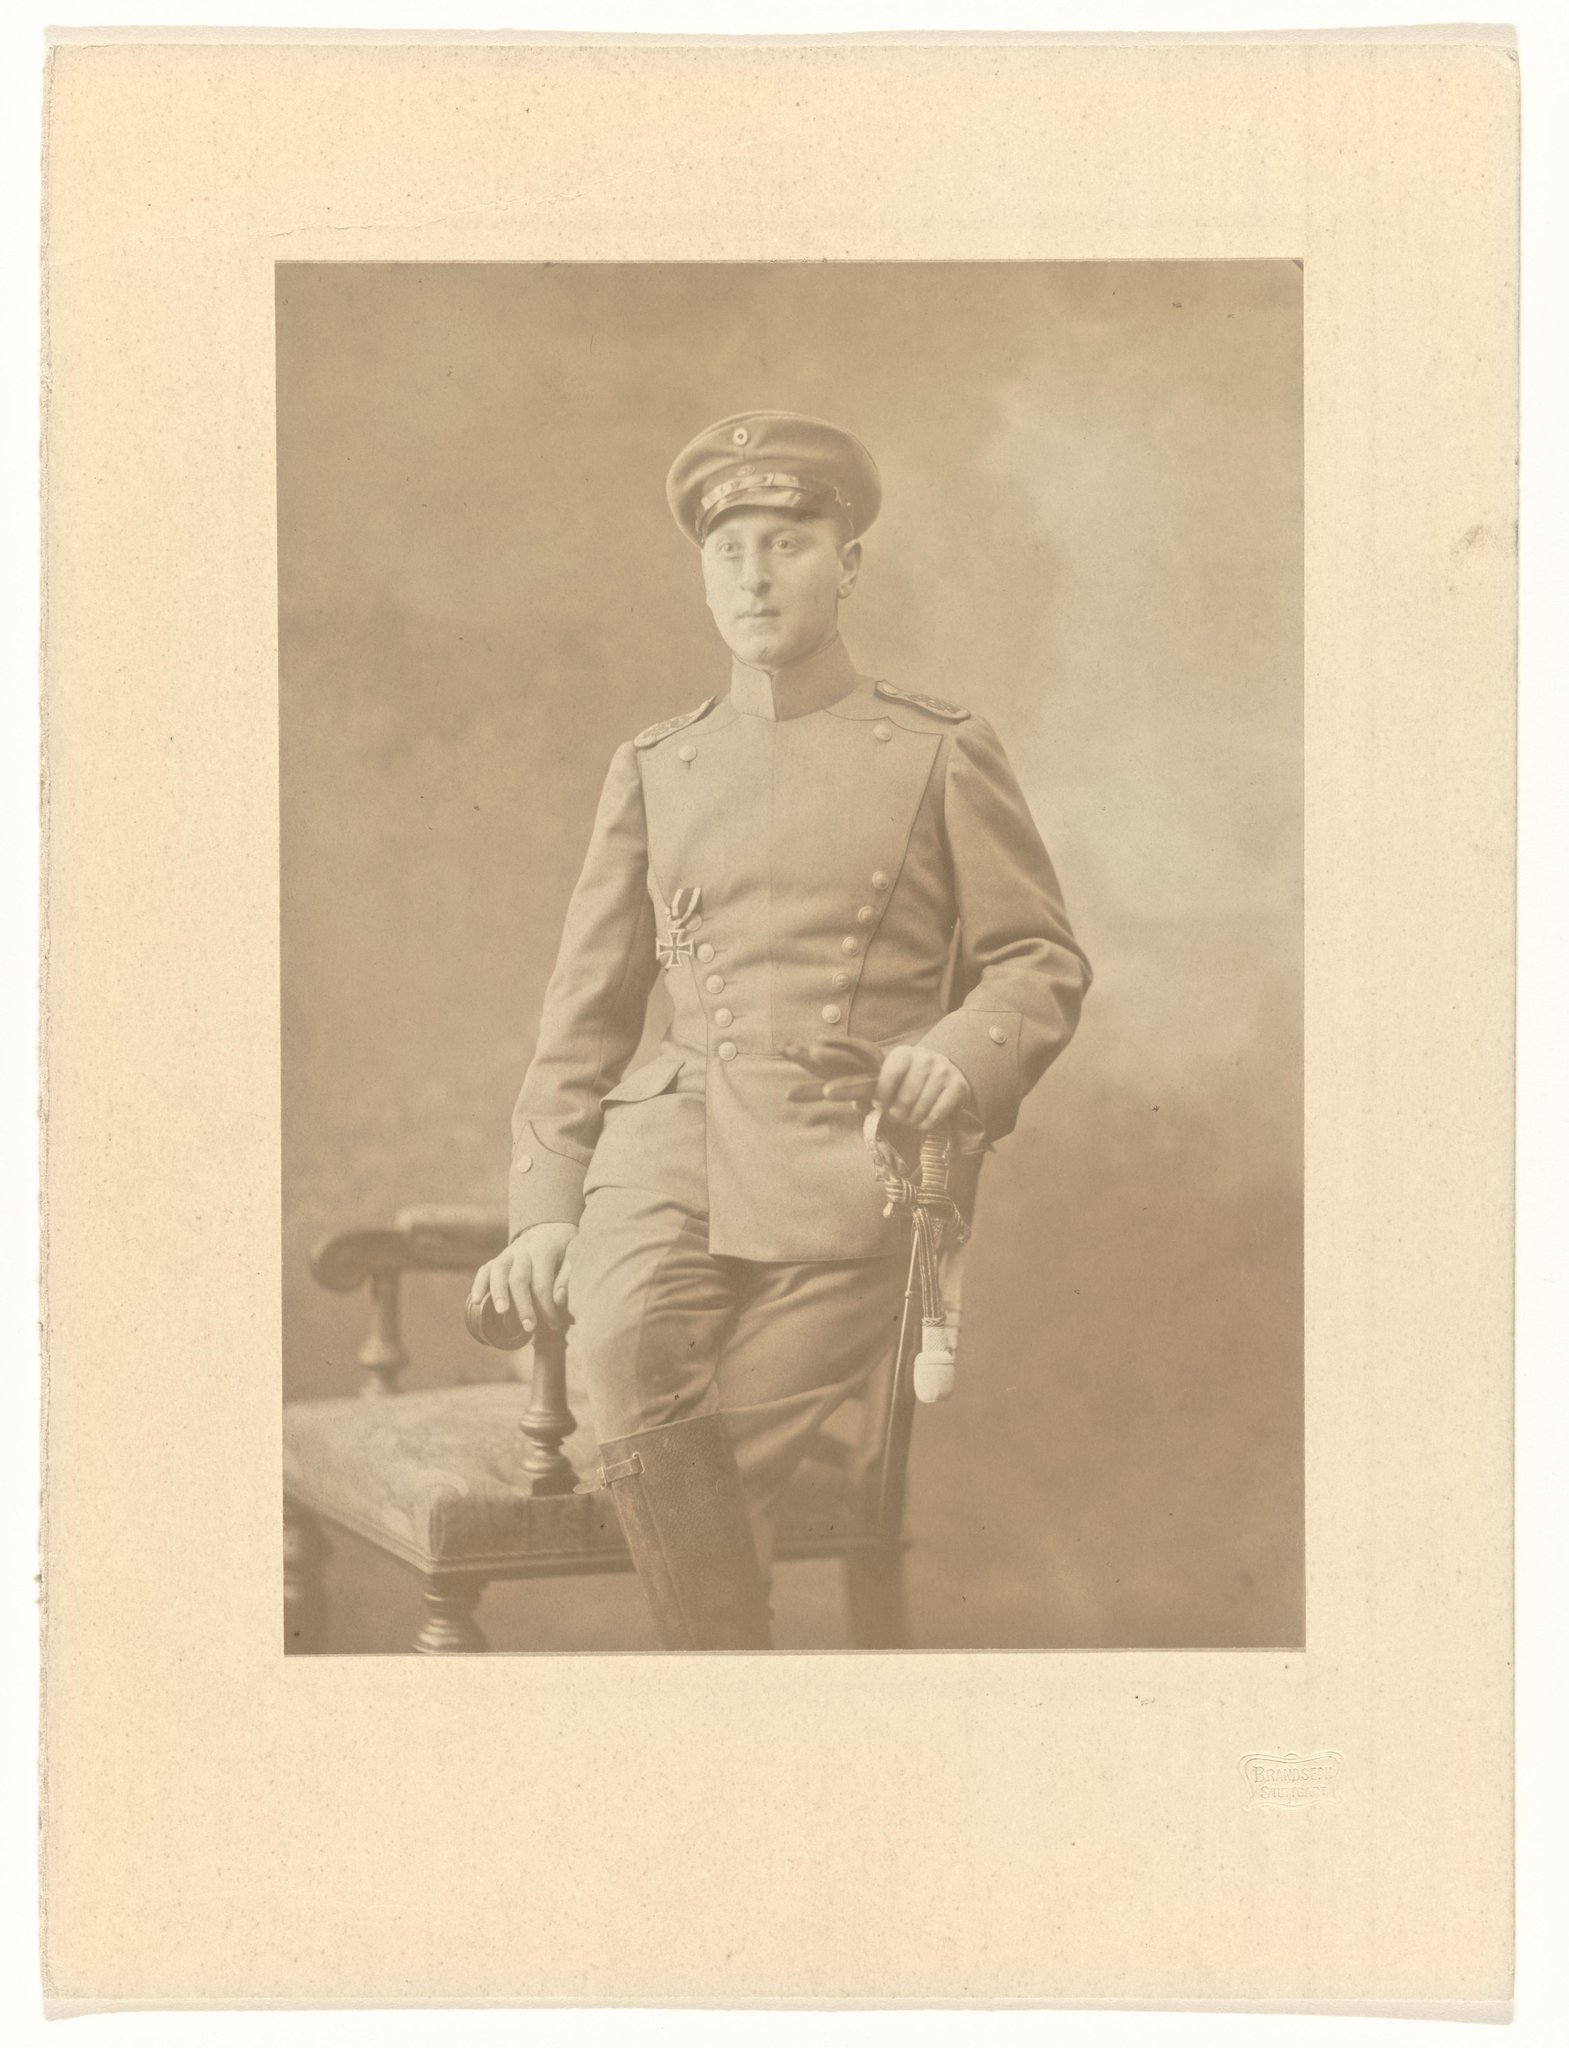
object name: photograph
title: Arthur Moos met sabel in het uniform van het Duitse leger, met het IJzeren Kruis op de borst, gezeten op een stoelleuning, december 1914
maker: hermann brandseph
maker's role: fotograaf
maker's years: 1826-1915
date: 1912-1914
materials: photographic support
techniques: gelatin silver print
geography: stuttgart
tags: arthur moos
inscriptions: company name: ‘Brandseph Stuttgart’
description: Arthur Moos met sabel in het uniform van het Duitse leger, met het IJzeren Kruis op de borst, gezeten op een stoelleuning.